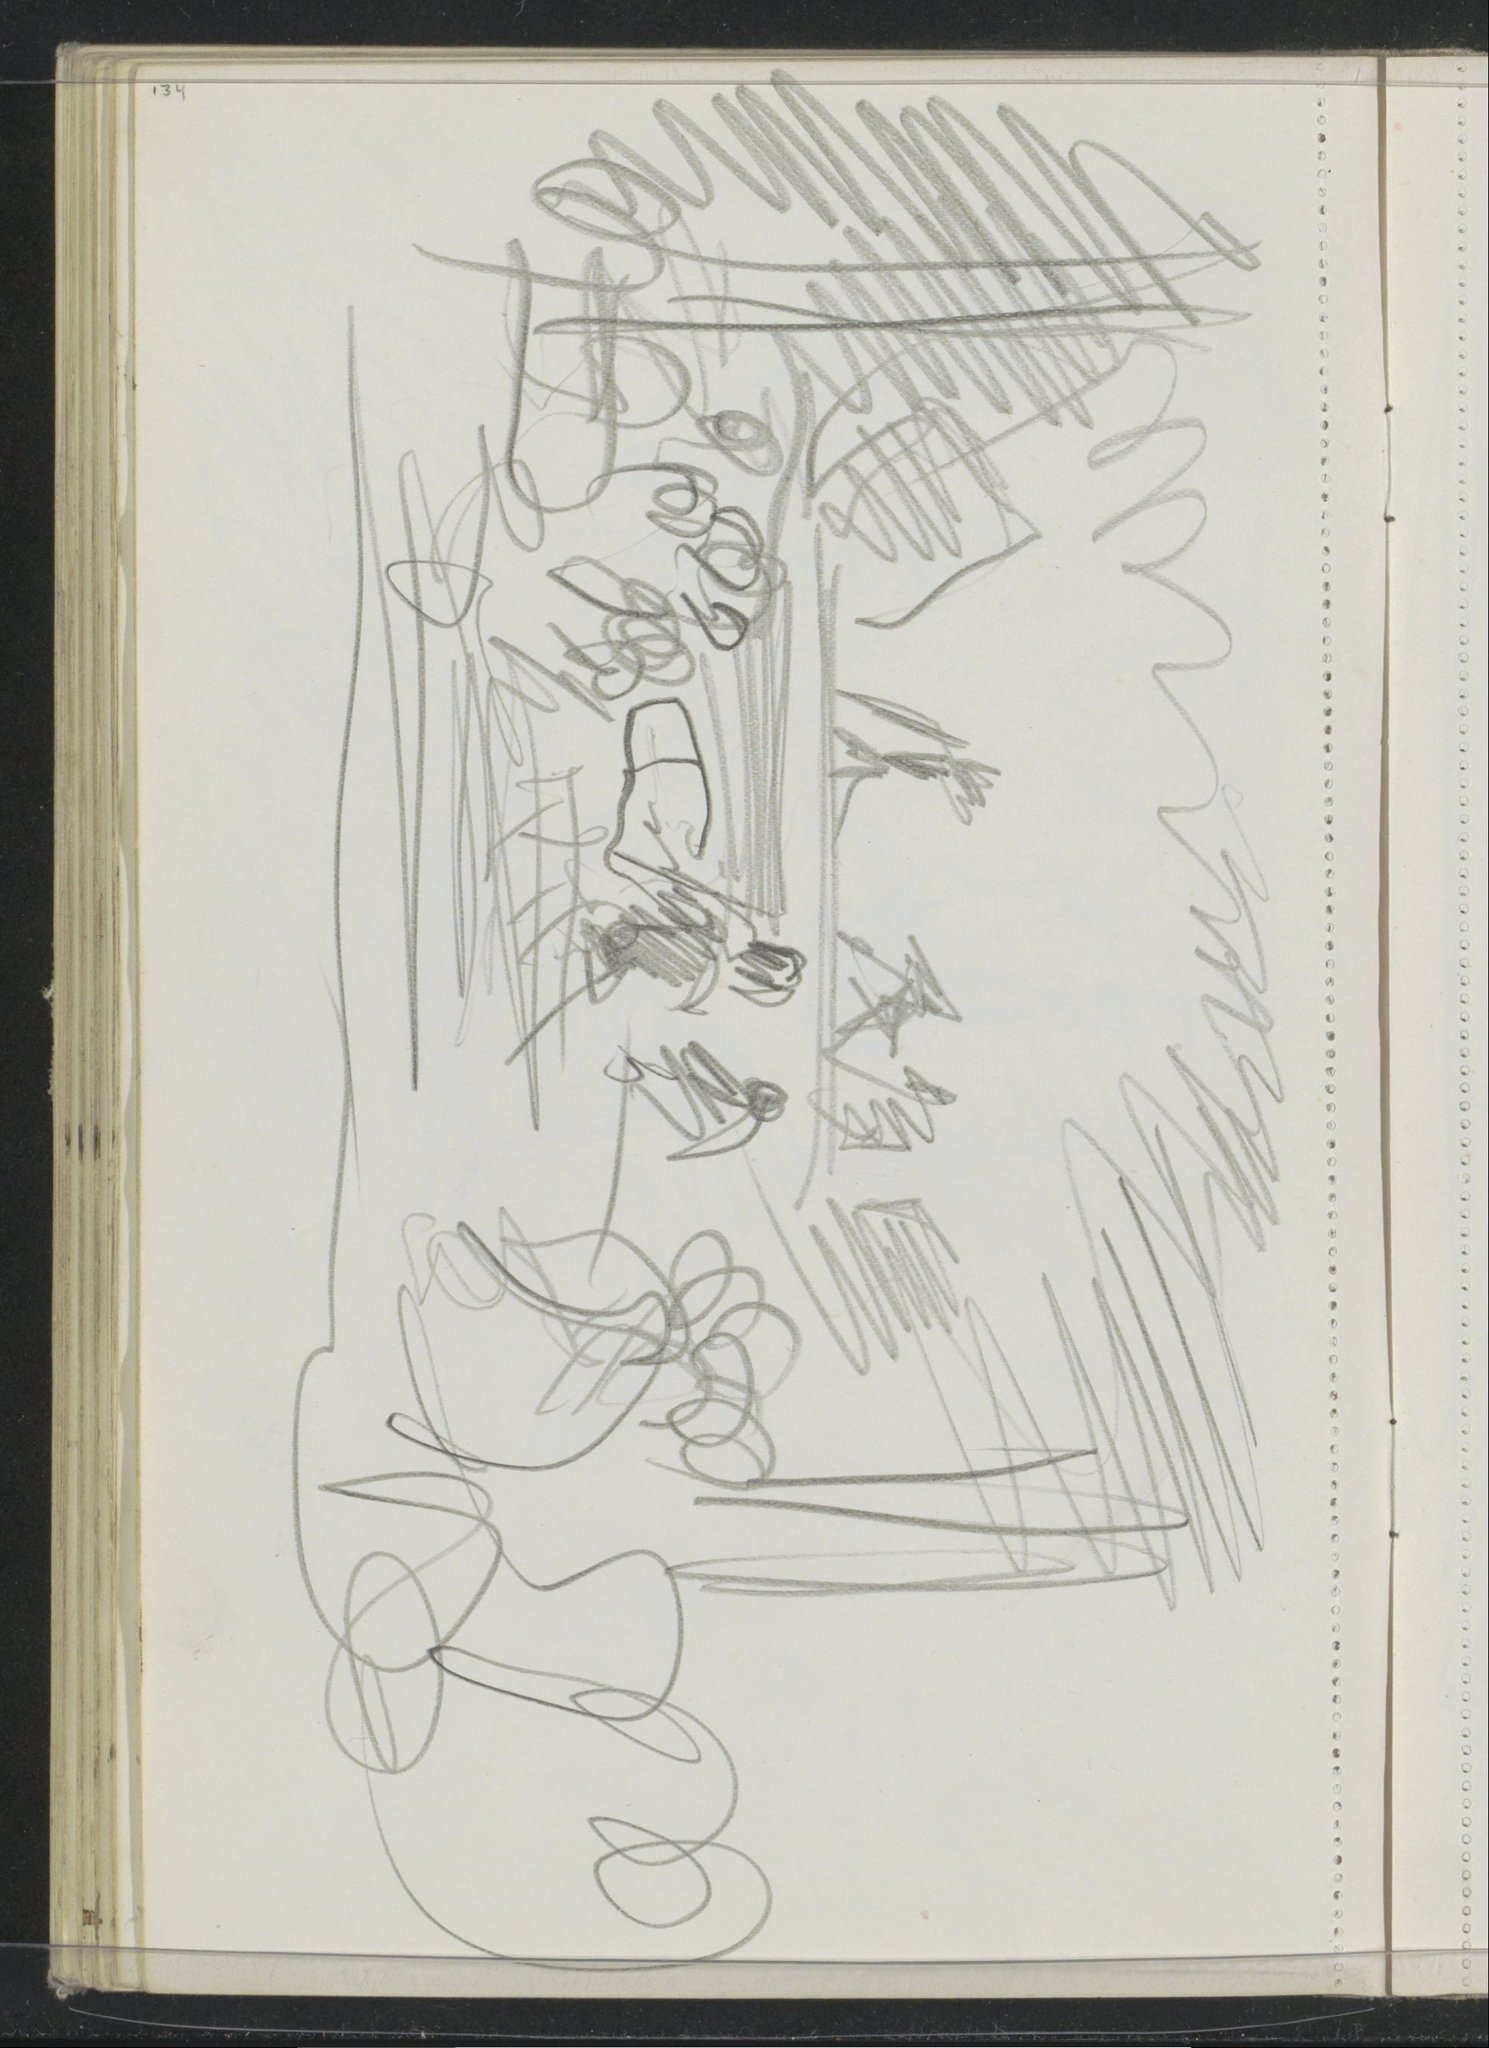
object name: sketchbook leaf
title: Voorstelling met zittend publiek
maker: marius bauer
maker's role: draughtsman, print maker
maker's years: 1867-1932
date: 1925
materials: paper, pencil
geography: indonesia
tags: performance, the audience ~ art performance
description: Mogelijk een Wayangvoorstelling. Pagina 134 uit een schetsboek met 74 bladen.